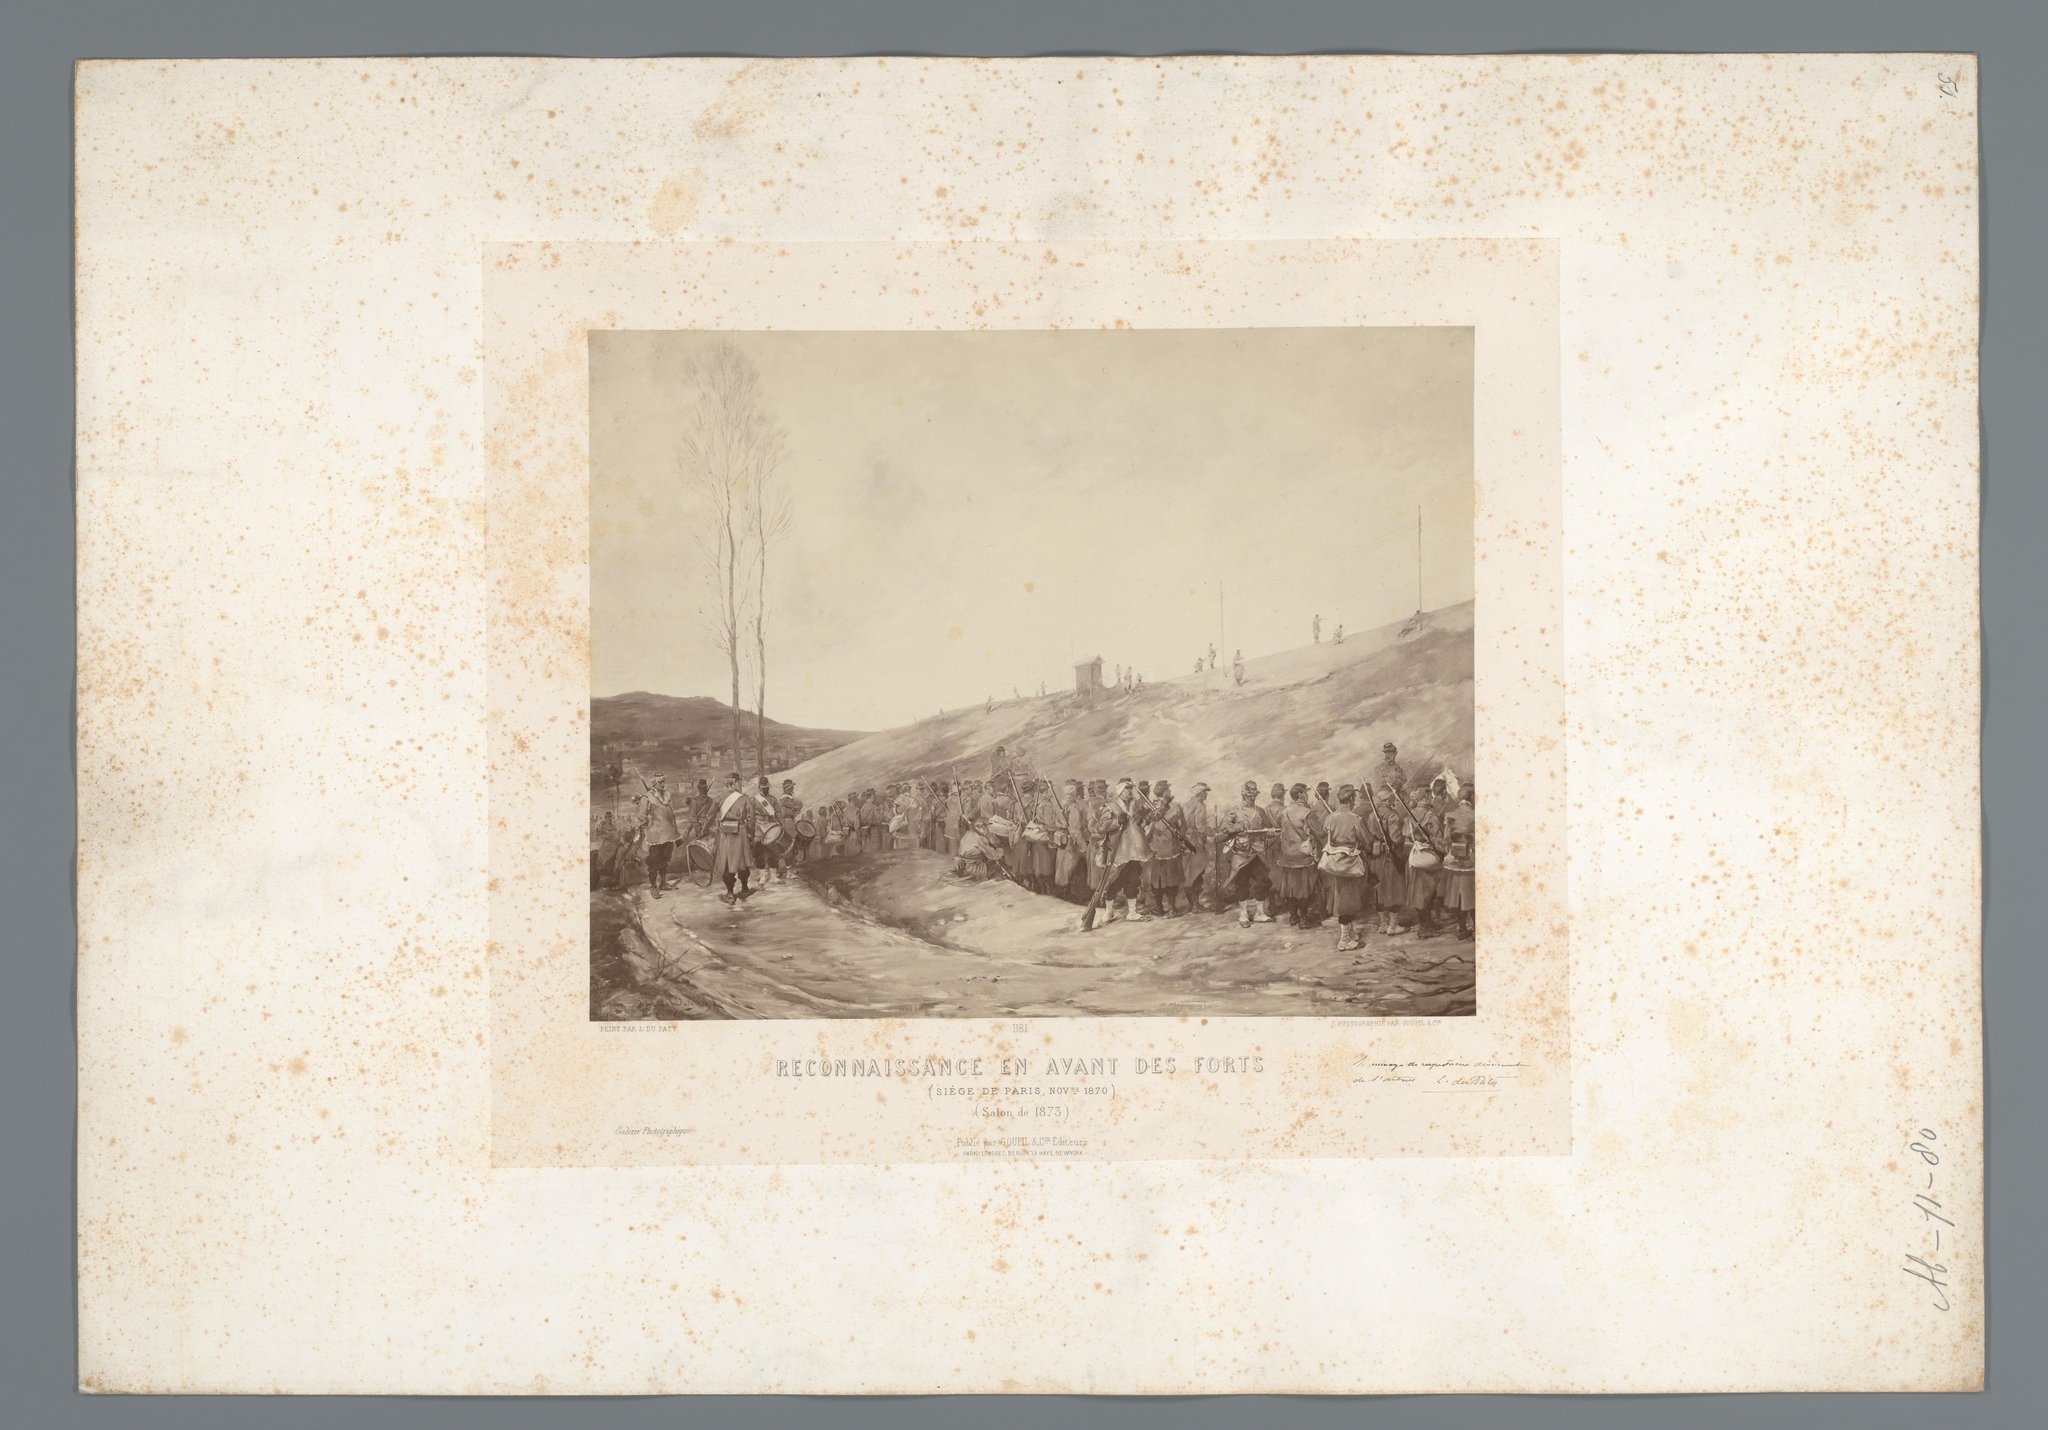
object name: reproduction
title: Galerie Photographique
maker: léon du paty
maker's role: painter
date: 1873-1884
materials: cardboard, paper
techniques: albumen print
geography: paris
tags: assembling of military forces; mobilization, troop concentration, etc.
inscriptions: inscription: ‘(Salon de 1873)’, inscription: ‘M-71-80’, number: ‘51.’, number: ‘1181’, inscription: ‘hommage d'inspecteur d[...]/ de l'auteur L. du Paty’